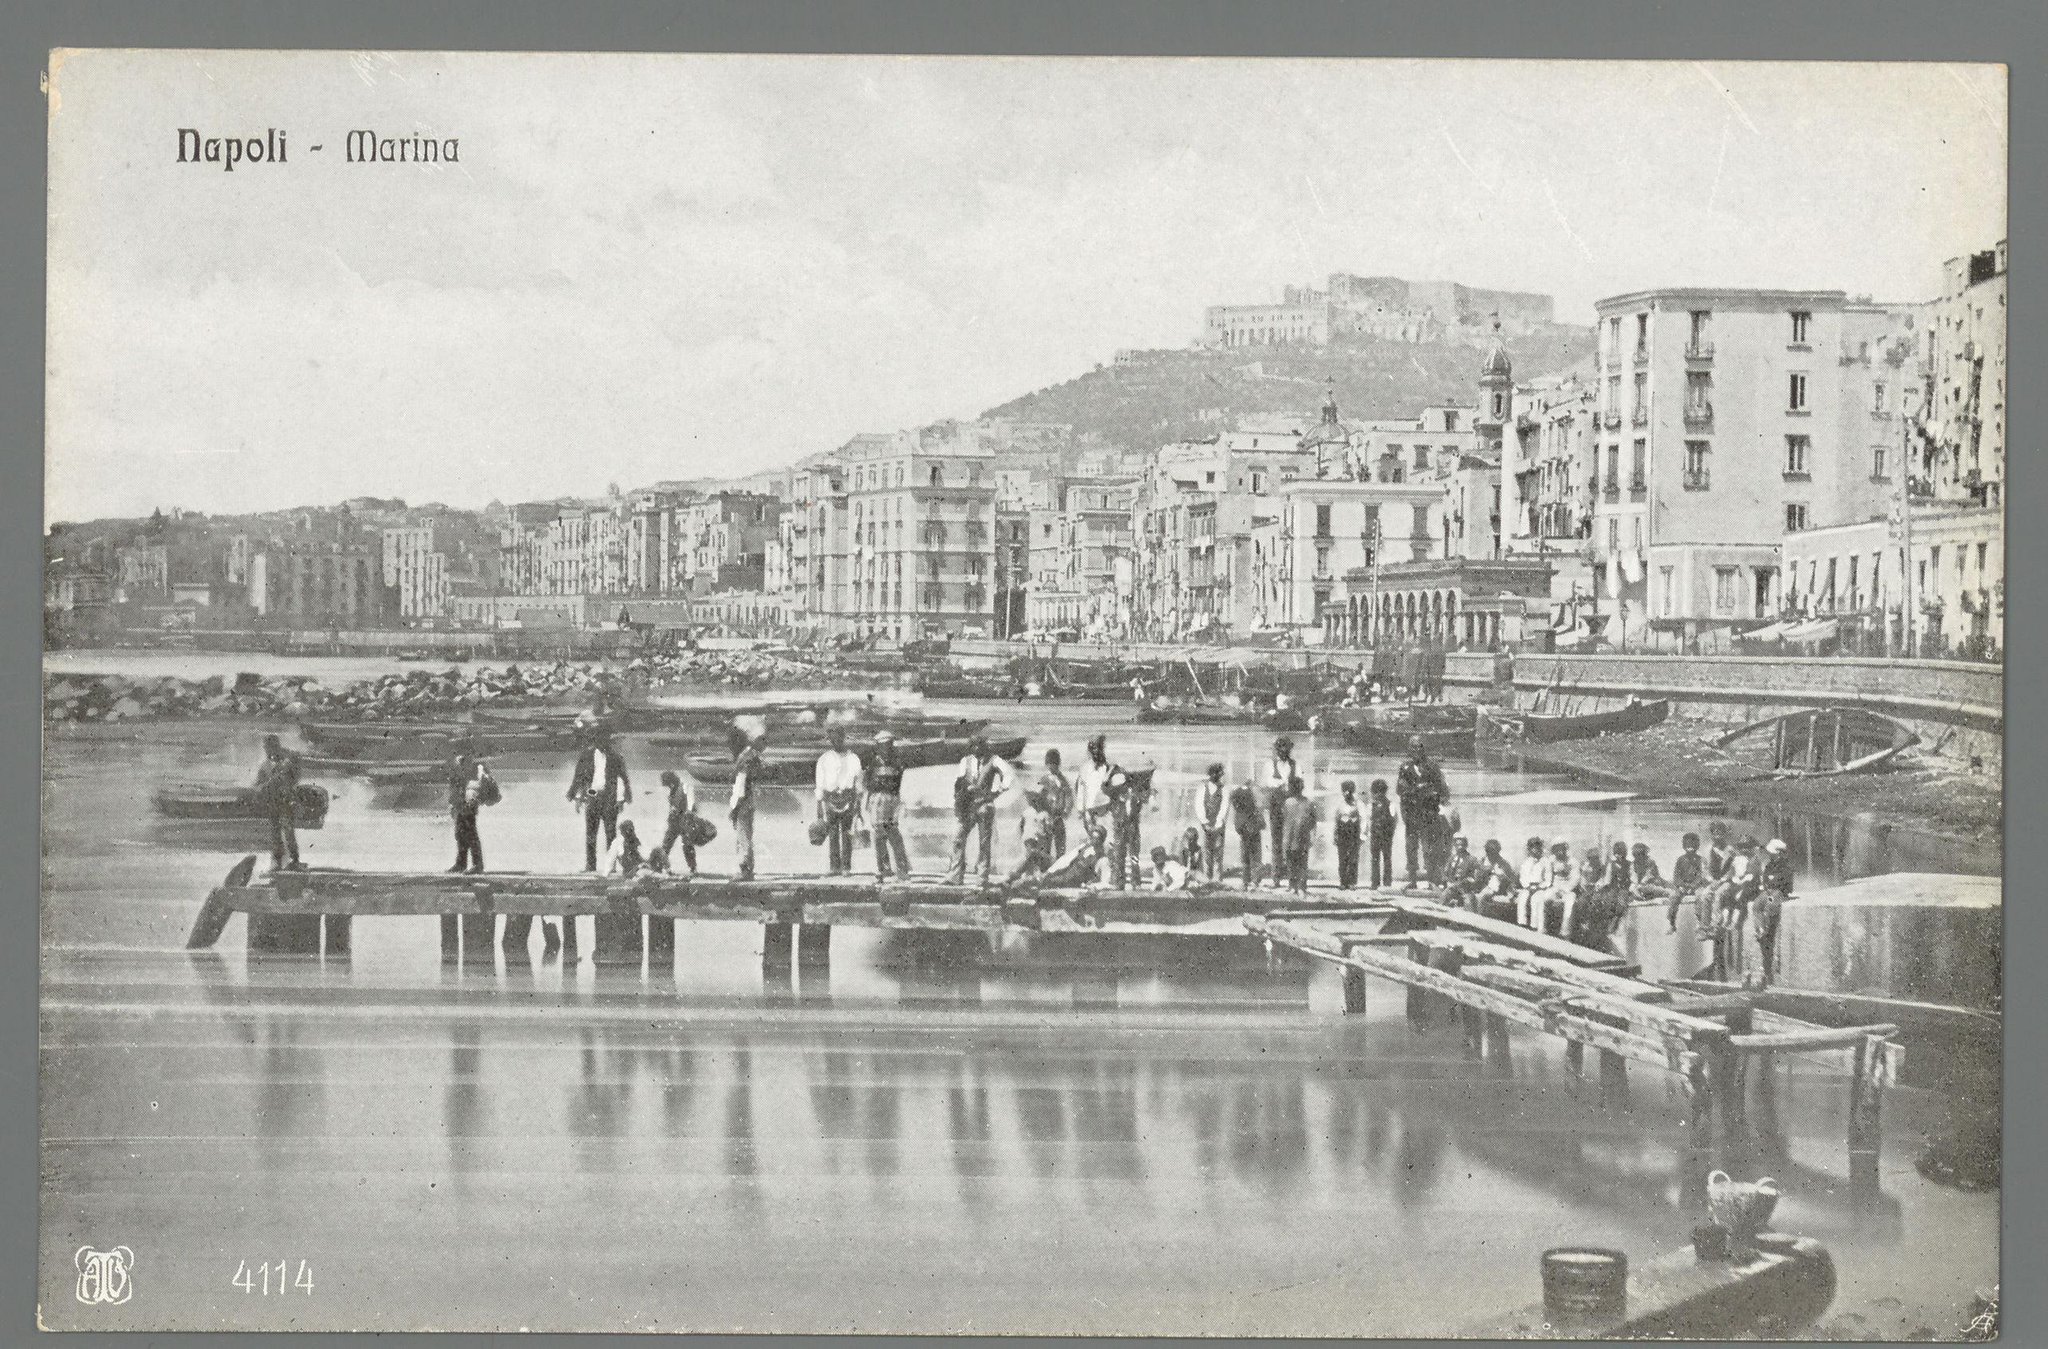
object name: ansichtkaart, prentbriefkaart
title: Napoli. Marina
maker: Anonymous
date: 1906-1910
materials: cardboard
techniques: autotype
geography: terni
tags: harbour, city-view, and landscape with man-made constructions (+ city(-scape) with figures, staffage), naples